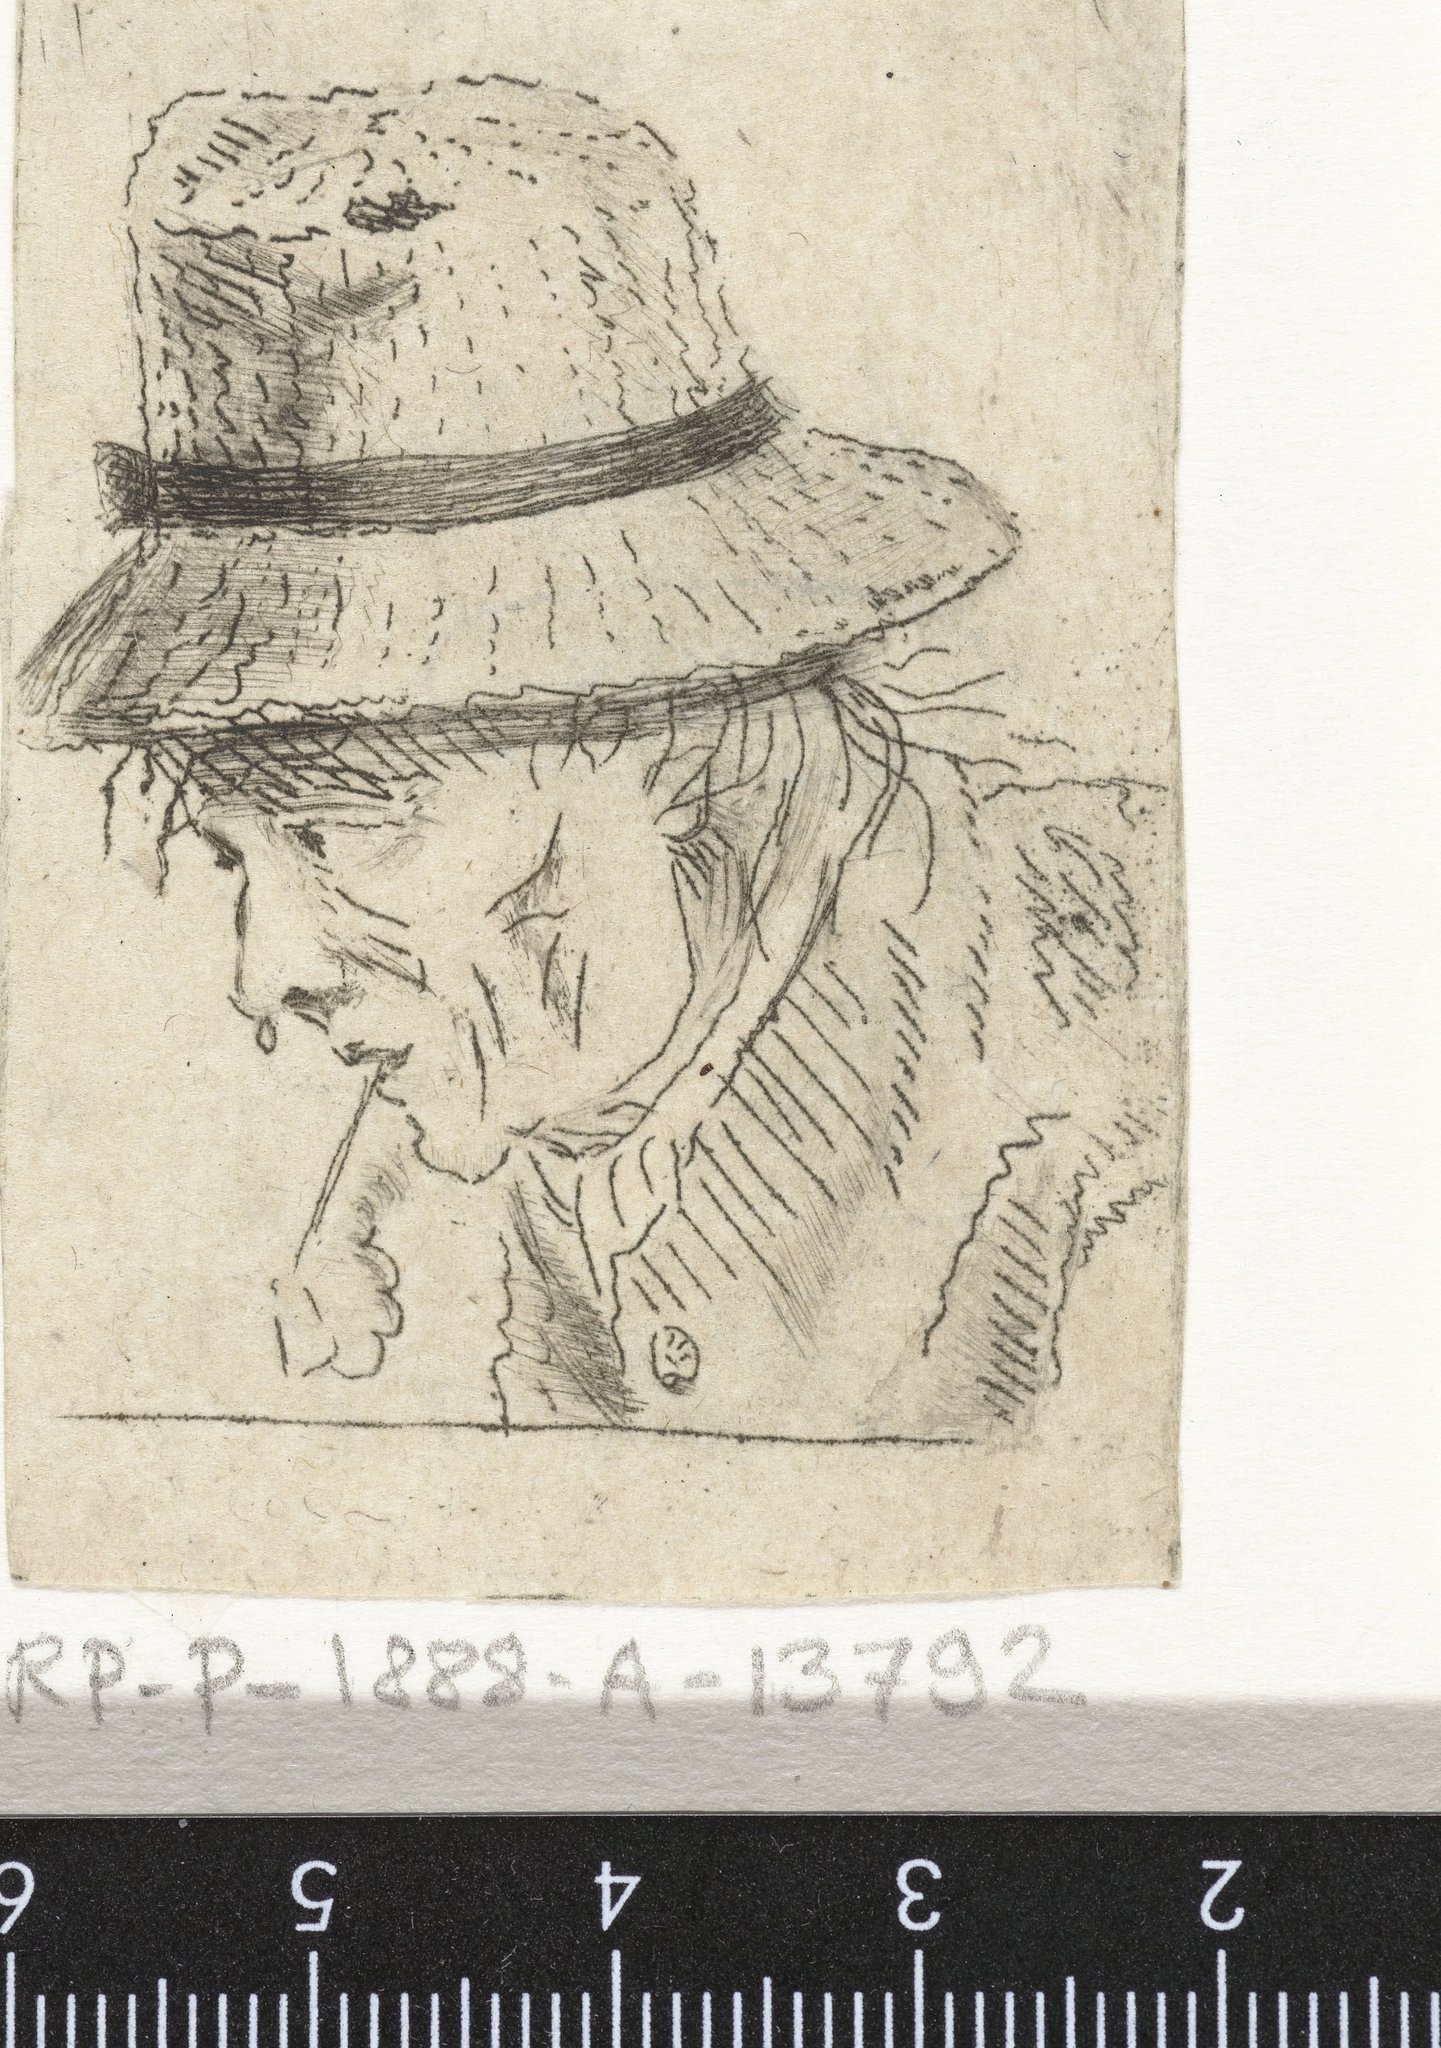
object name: print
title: Manshoofd met hoed en pijp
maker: louis bernard coclers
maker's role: draughtsman, print maker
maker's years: 1741-1817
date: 1756-1817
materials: paper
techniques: aquatint, drypoint, etching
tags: pipe ~ tobacco, head-gear: hat (+ men's clothes), pipe ~ tobacco (+ taking (particular) foodstuffs: eating, drinking, smoking, chewing, etc.)